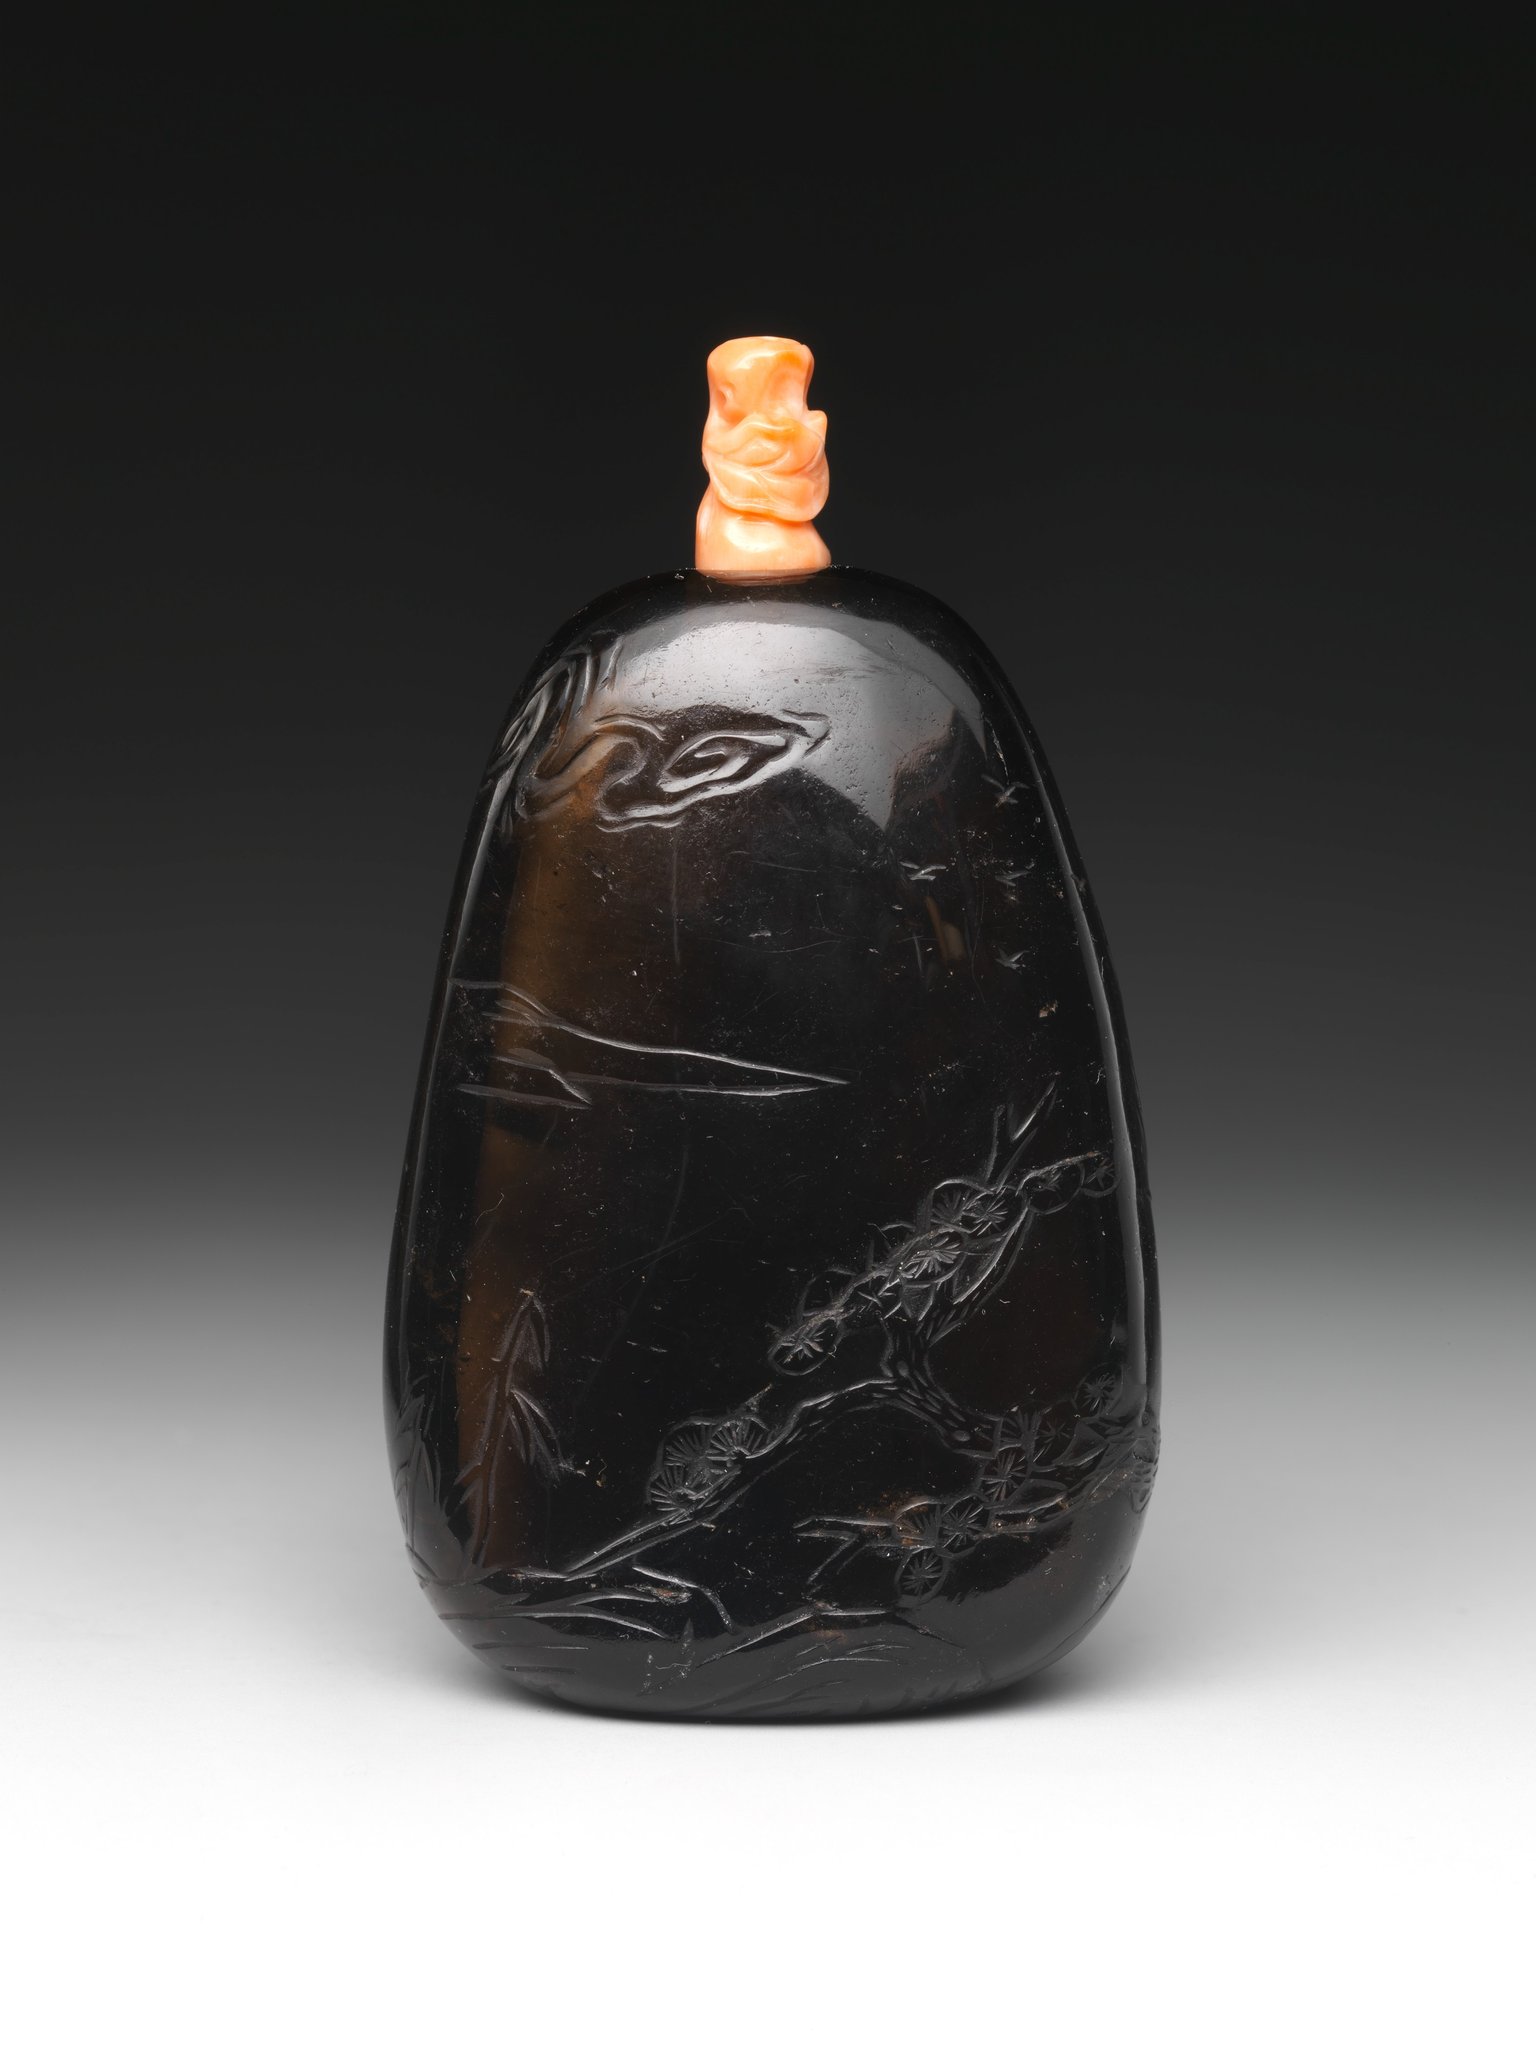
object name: snuff bottle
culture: chinese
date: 1736-1795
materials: coral, crystal